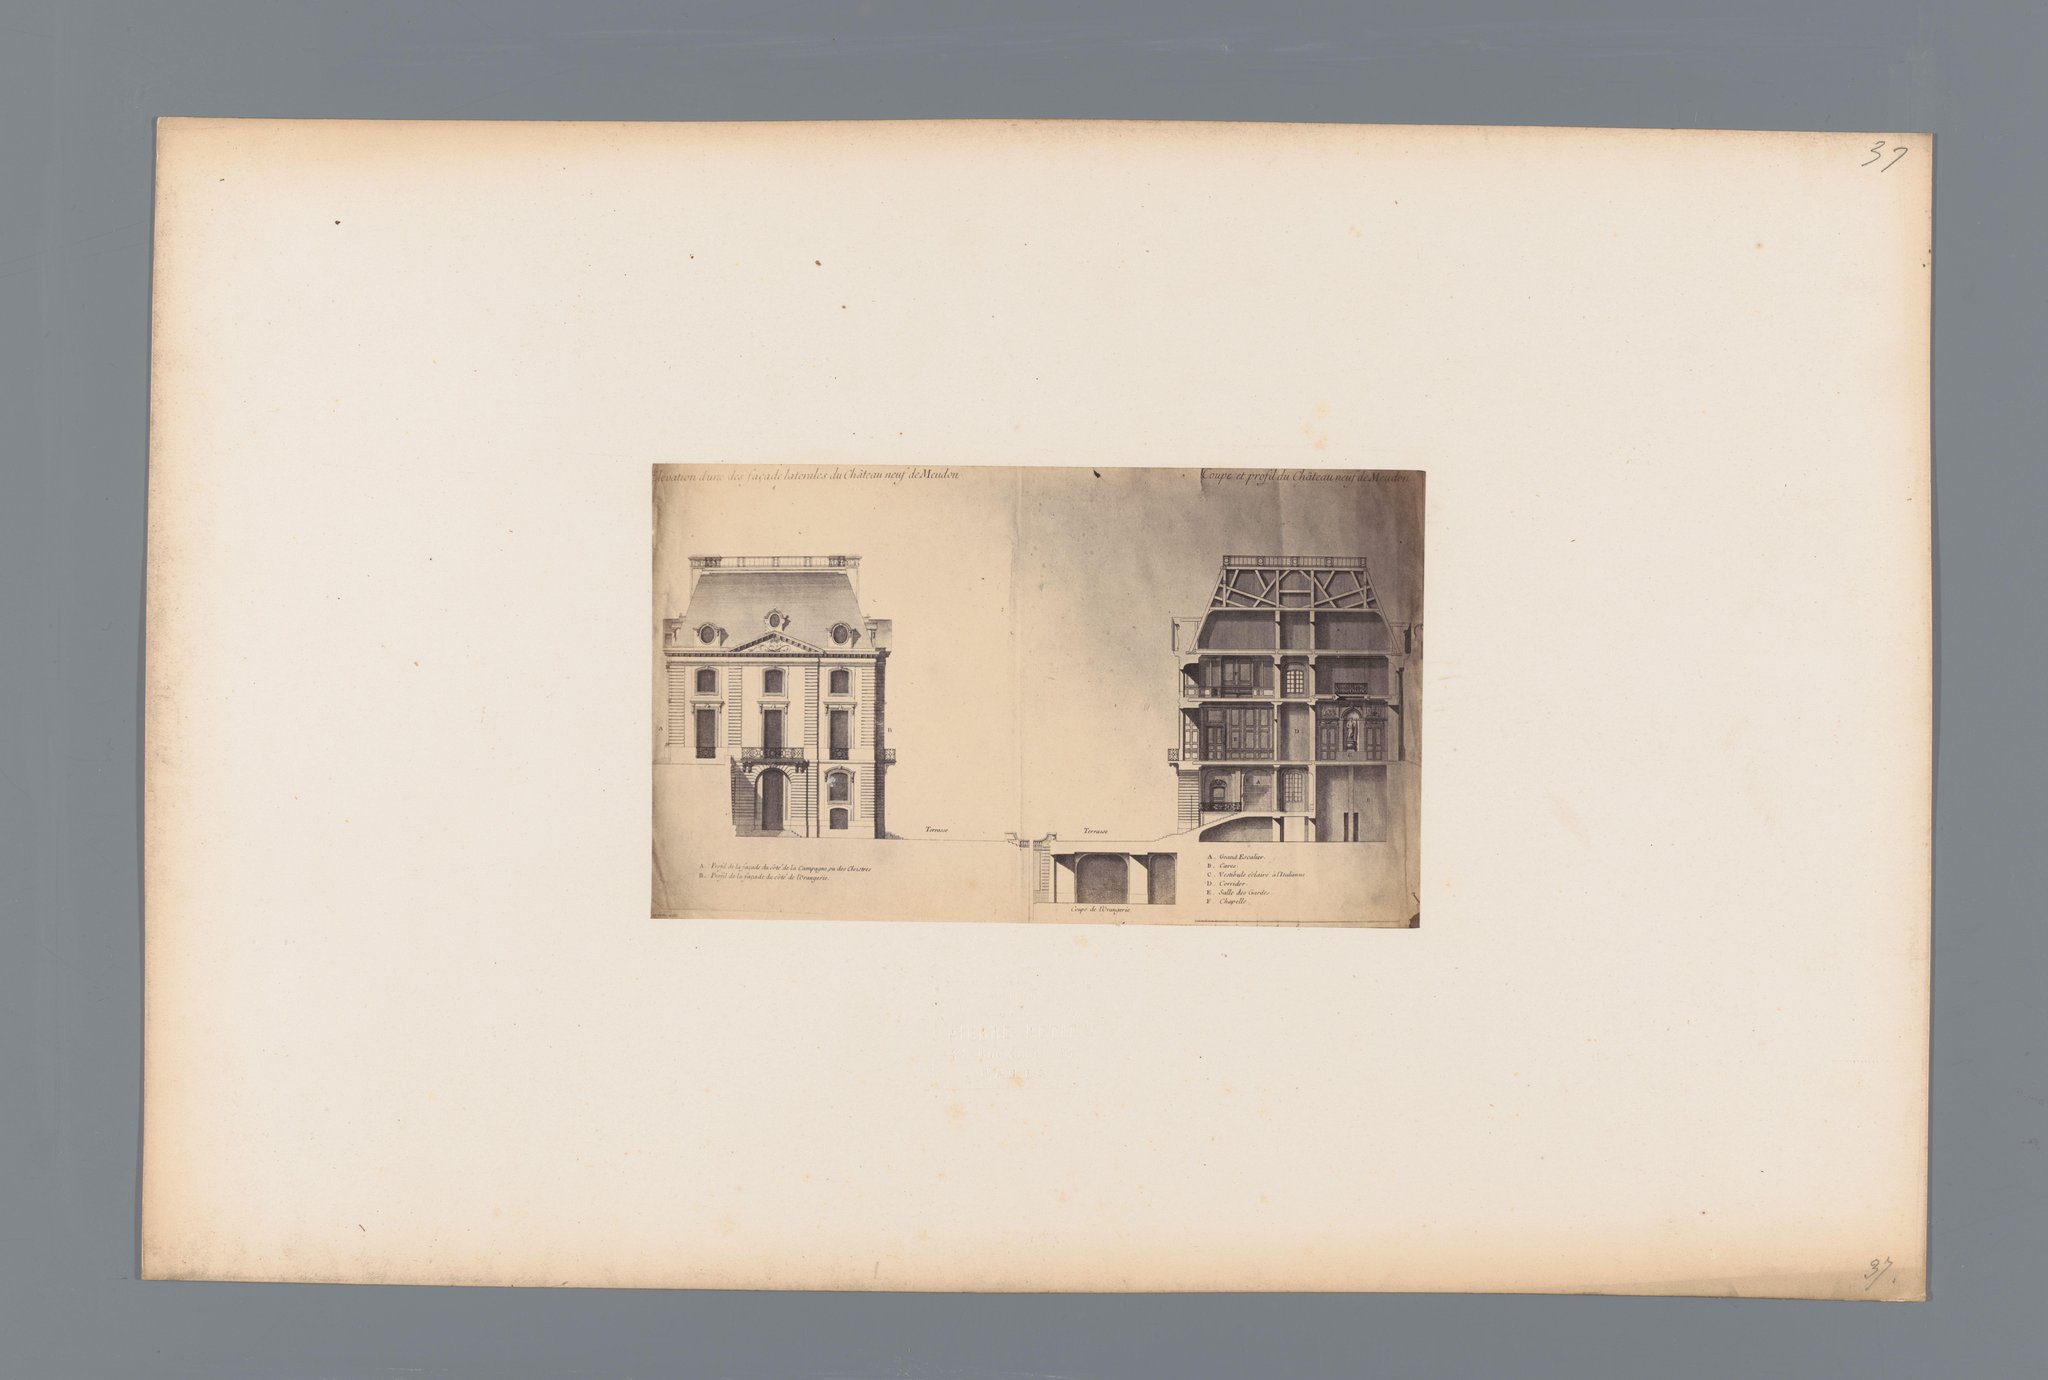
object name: photograph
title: Fotoreproductie van een ontwerp van een zijaanzicht en een doorsnee van het kasteel van Meudon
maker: pierre petit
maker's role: fotograaf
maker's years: 1832-1909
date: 1860-1865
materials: photographic support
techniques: albumen print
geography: paris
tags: castle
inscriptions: check stamp: ‘PHOTOGRAPHIE des DEUX MONDES/ PIERRE PETIT/ 31, Rue Cadet, 31/ PARIS’, number: ‘37’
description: Deze foto maakt deel uit van een omslag met 38 foto's en 17 tekstbladen.